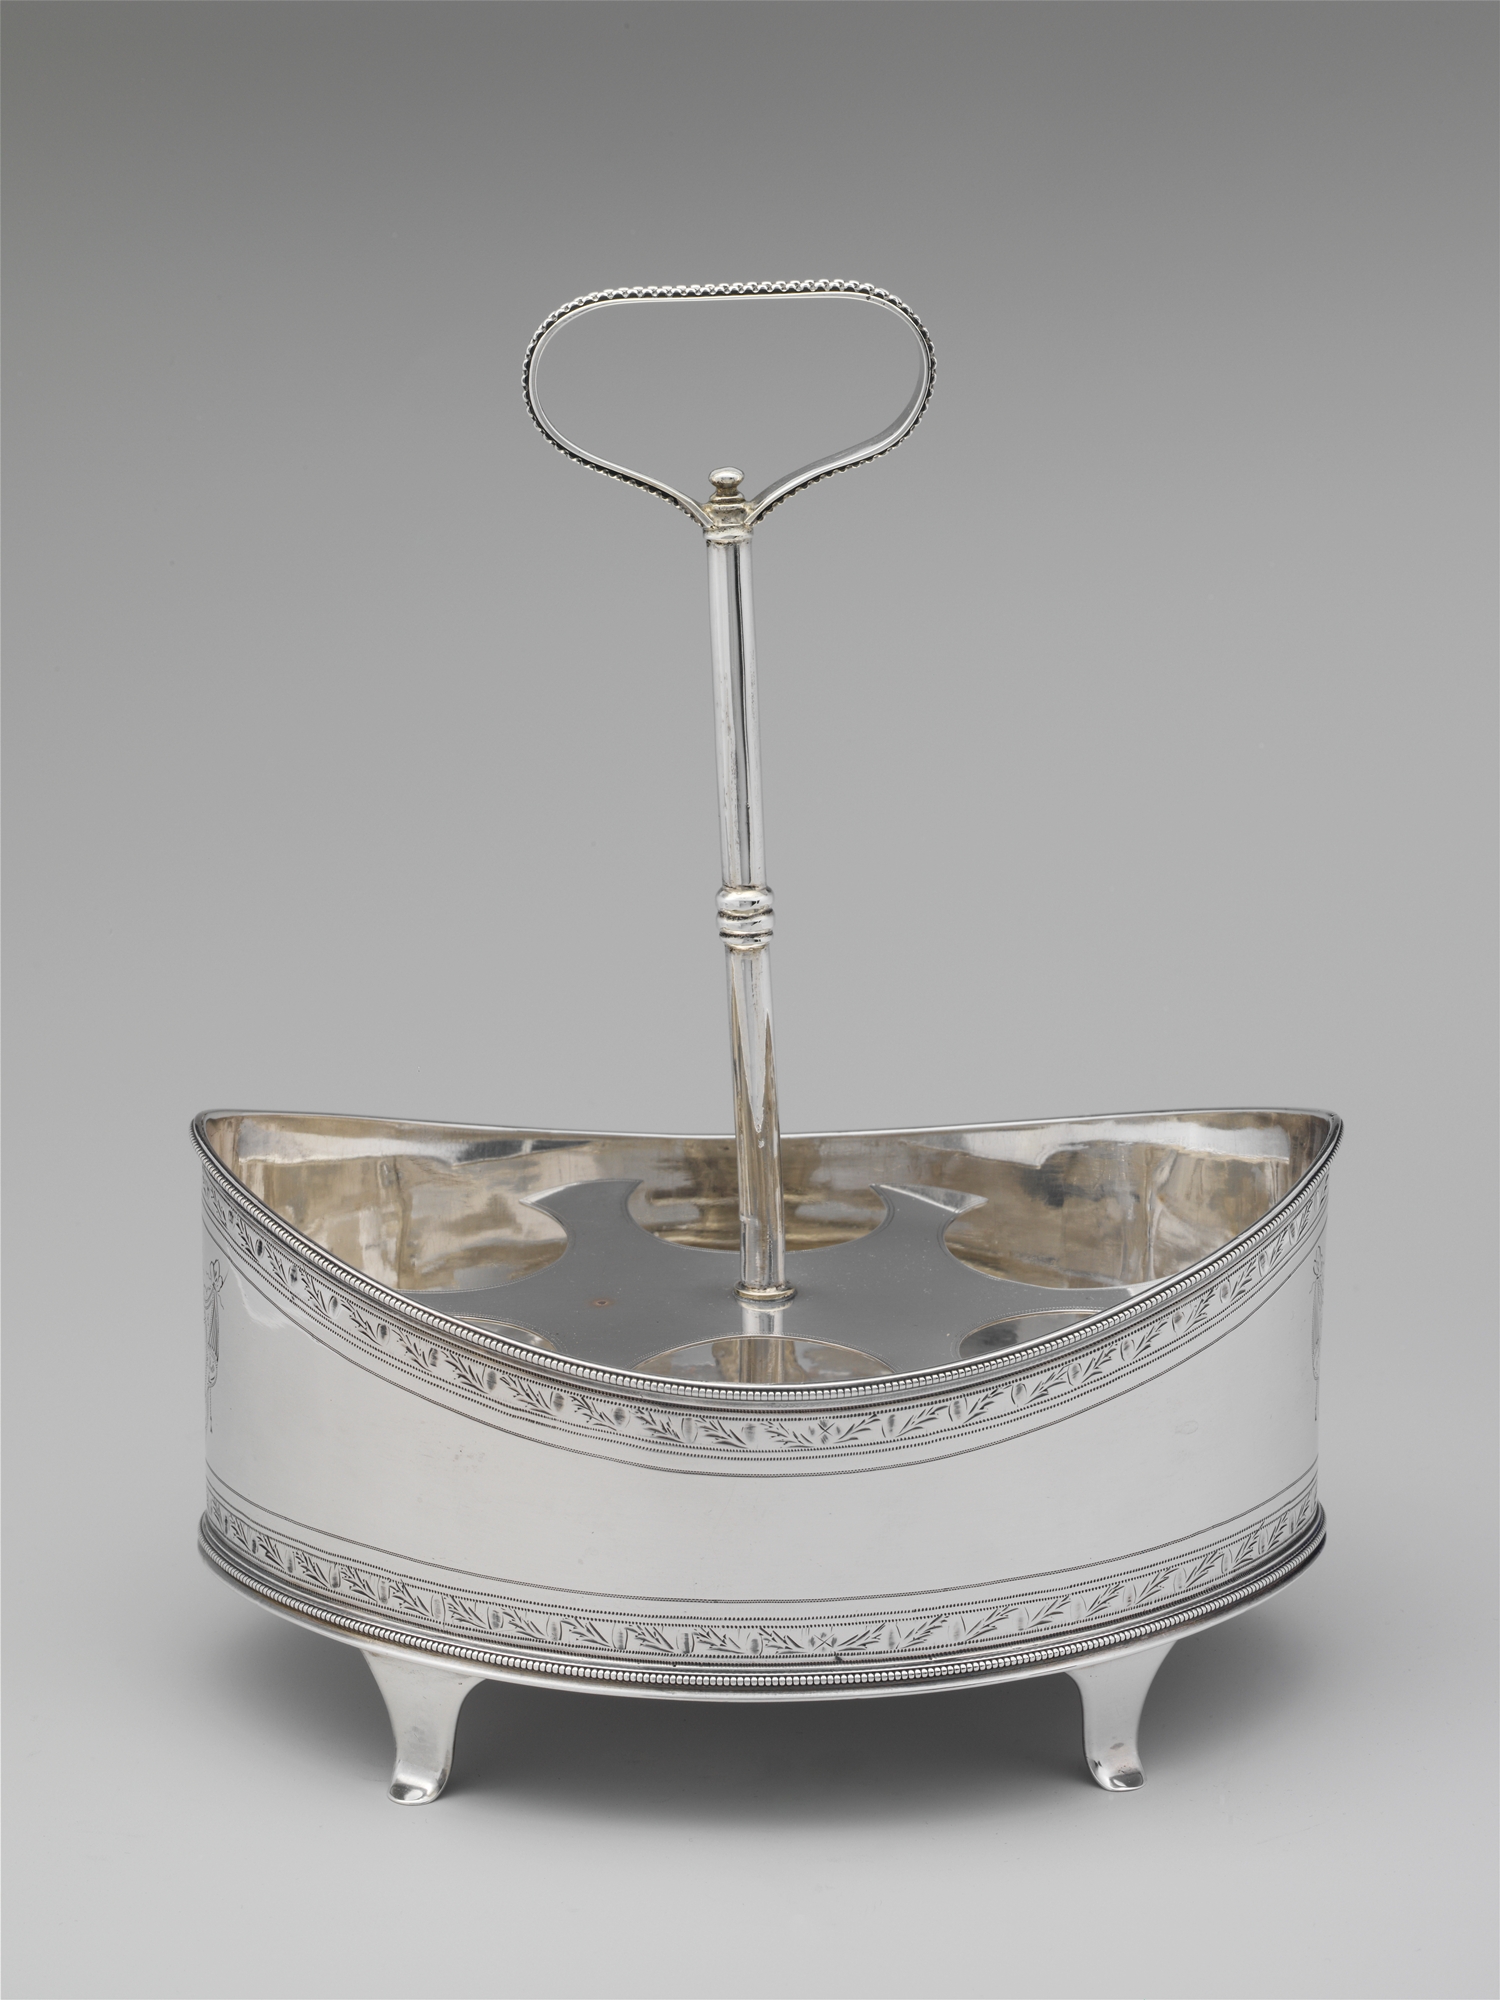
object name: cruet stand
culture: american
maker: joseph dubois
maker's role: maker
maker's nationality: american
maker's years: 1767-1798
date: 1796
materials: silver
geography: united states